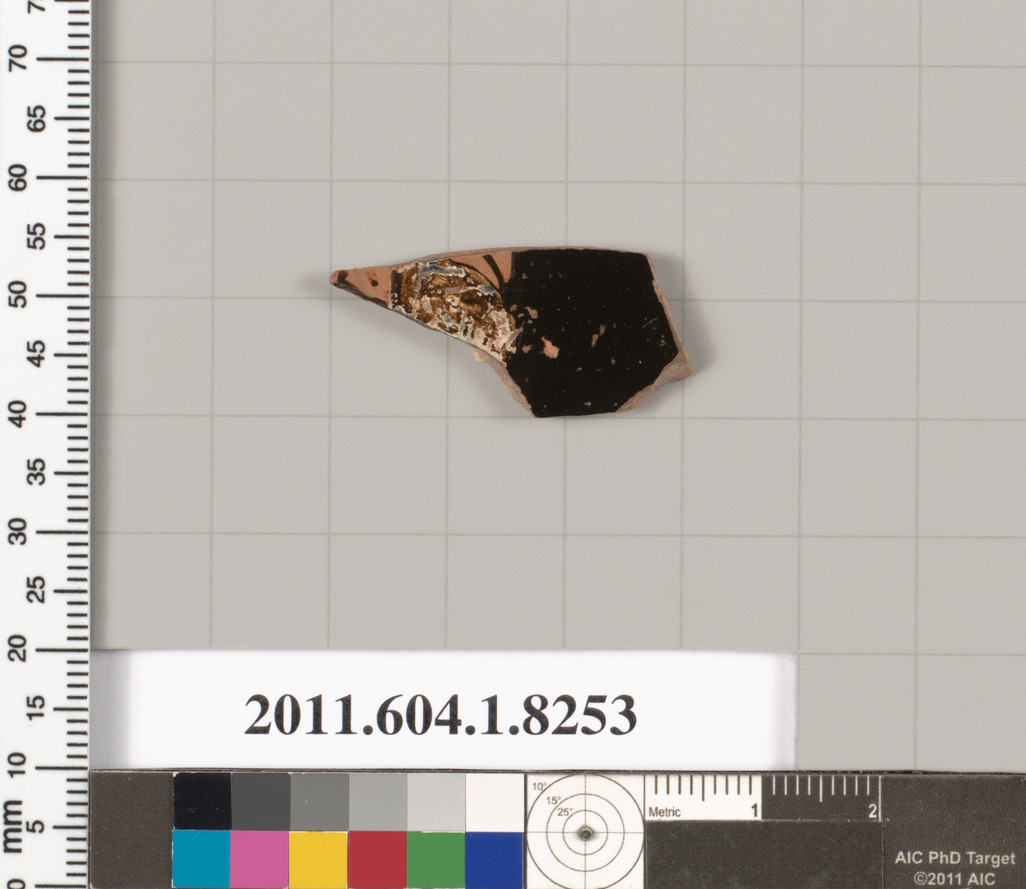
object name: kylix fragment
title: Terracotta fragment of a kylix (drinking cup)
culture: greek, attic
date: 520-510 BCE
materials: terracotta